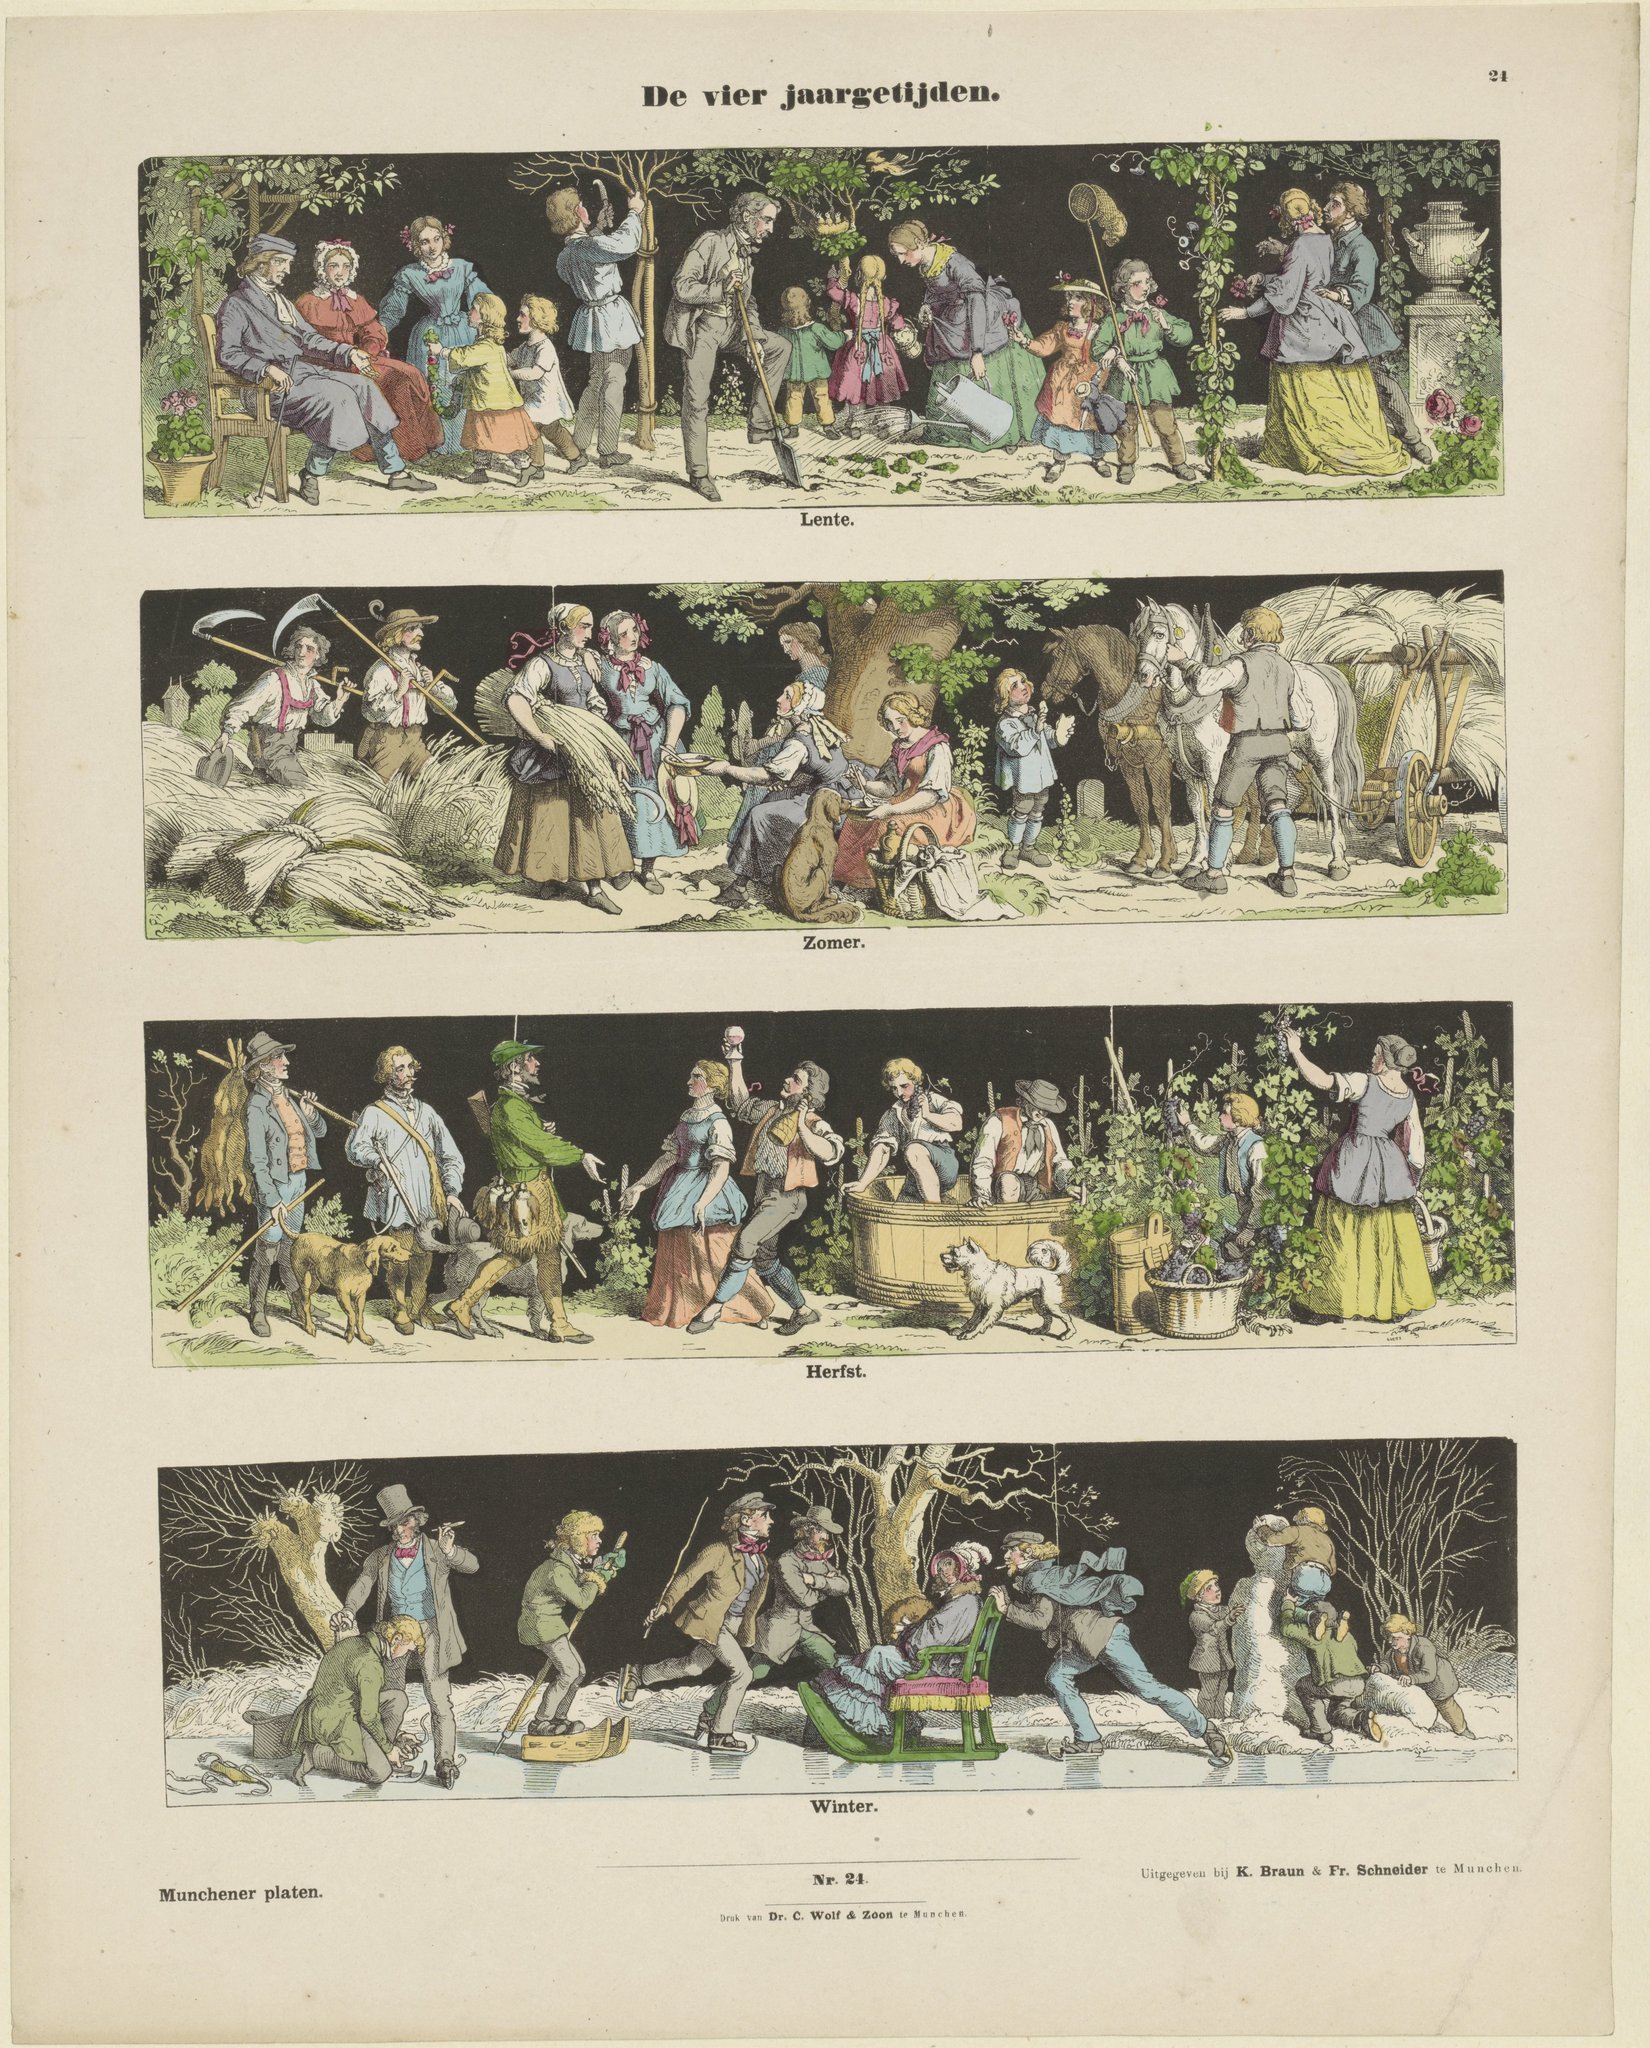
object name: print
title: De vier jaargetijden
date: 1843-1920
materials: paper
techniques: colour, letterpress printing, engraving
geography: munich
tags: the four seasons of the year ~ human activities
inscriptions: collector's mark: Lugt 2760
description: Blad met 4 horizontale rijen met voorstellingen van de vier jaargetijden uitgebeeld door typische activiteiten per seizoen, tegen een zwarte achtergrond. Onder elke afbeelding de naam van het seizoen. Genummerd midden onder: Nr. 24. Genummerd rechtsboven: 24.